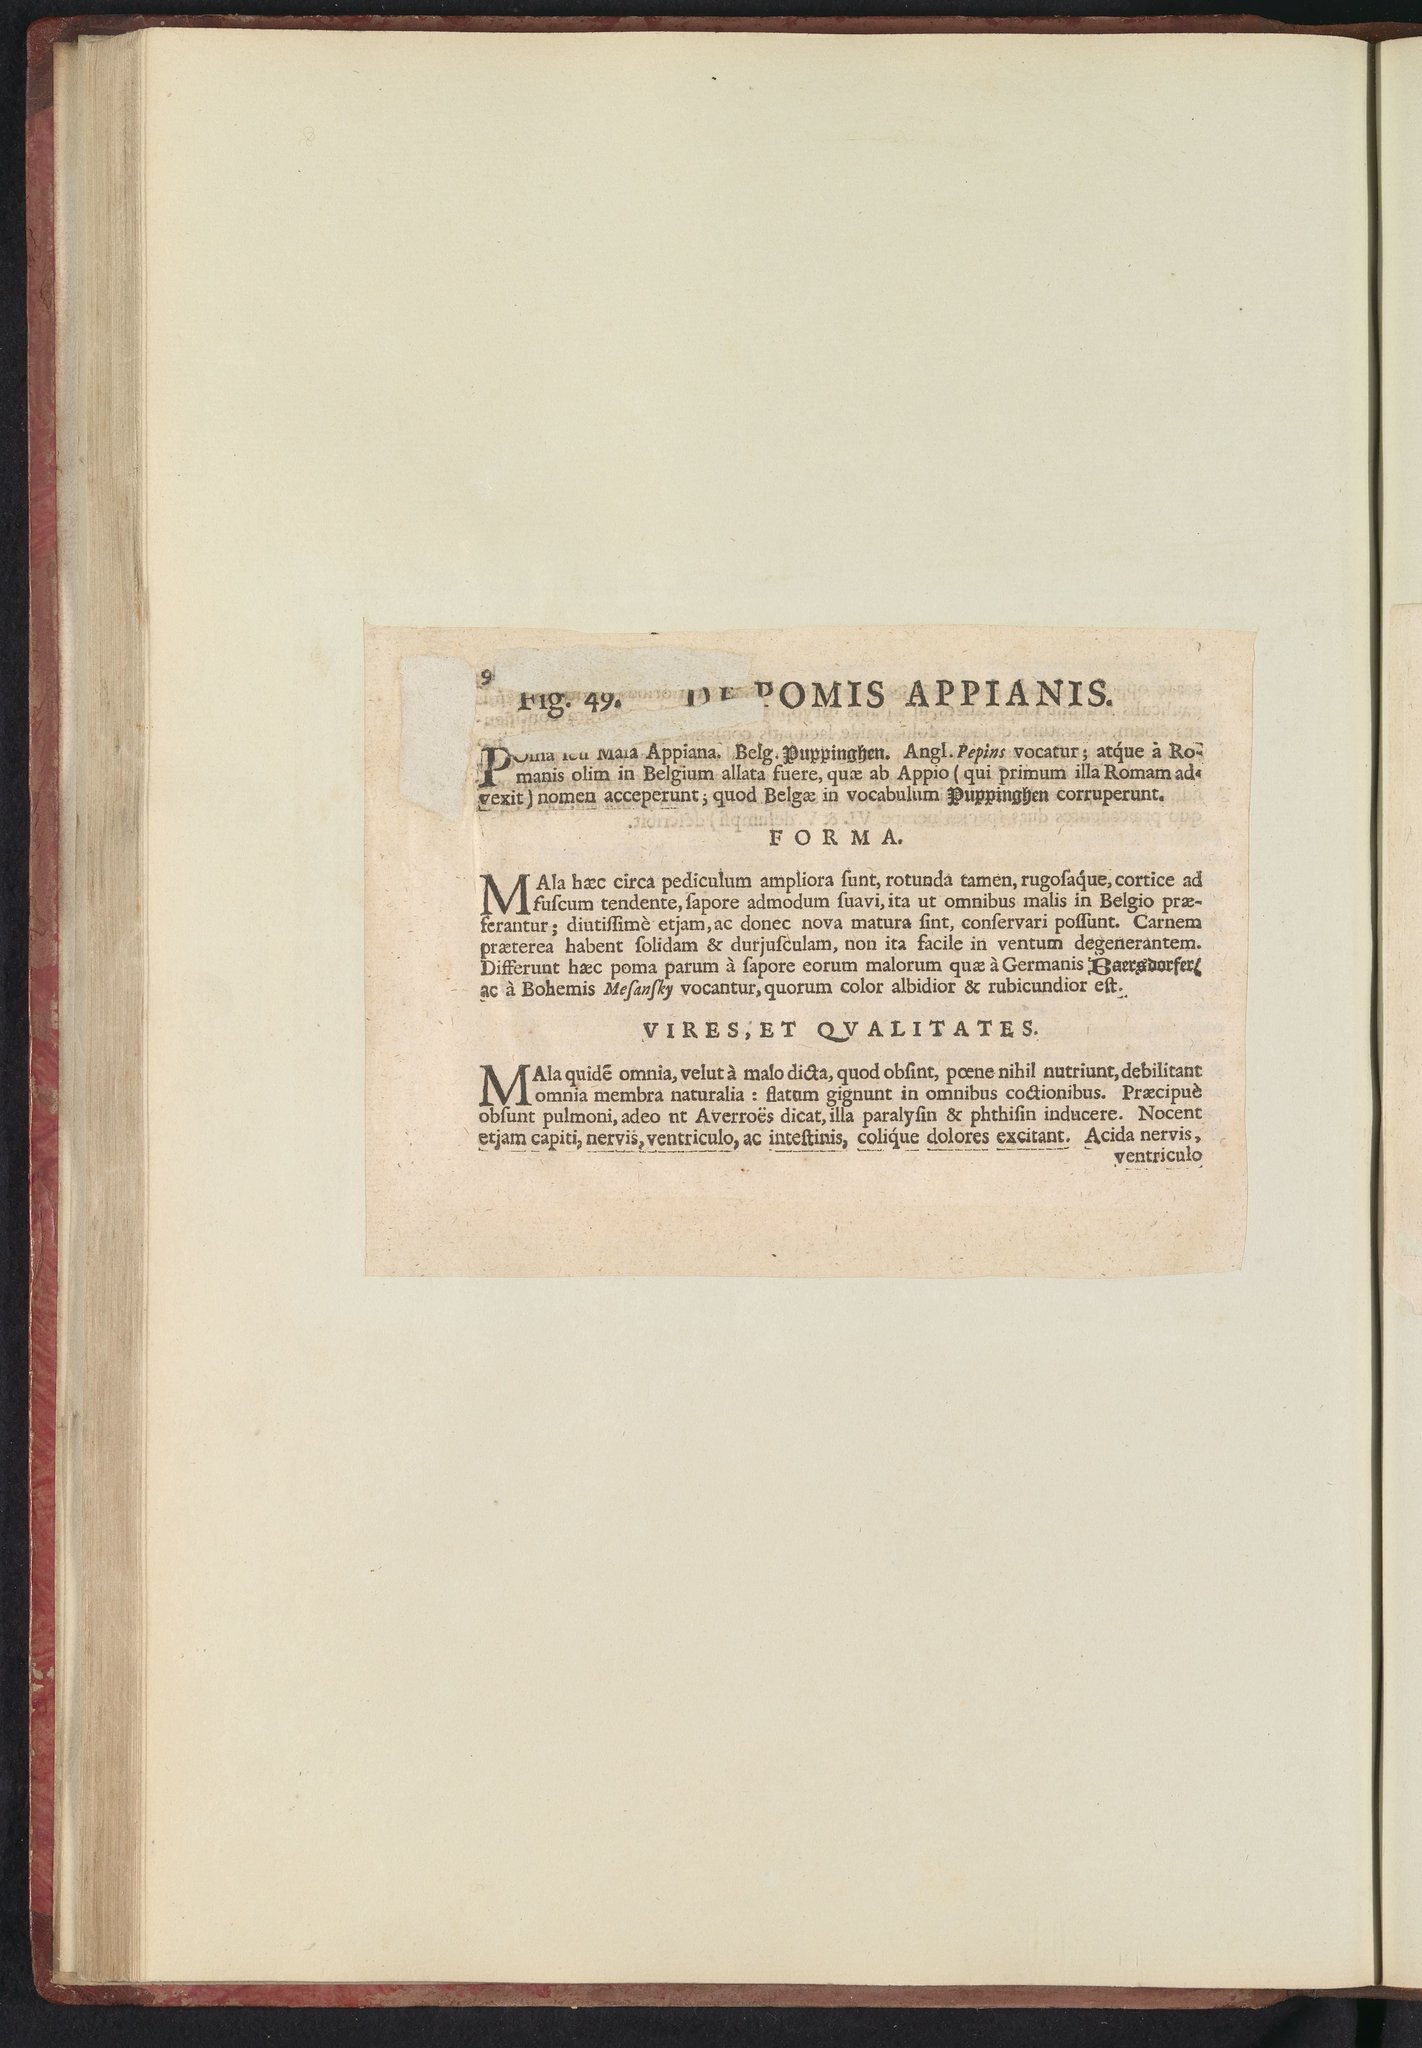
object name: text sheet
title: Fig. 49 'De Pomis Appianis' in De Boodts herbarium van 1640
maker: anselmus boëtius de boodt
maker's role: draughtsman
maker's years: 1550-1632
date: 1640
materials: ink, paper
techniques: letterpress printing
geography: bruges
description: Beschrijving bij Fig. 49 op p. 96 in: Anselmi Boëtii de Boot I.C. Brugensis & Rodolphi II. Imp. Roman. medici a cubiculis Florum, Herbarum, ac fructuum selectiorum icones, & vires pleraeque hactenus ignotæ. Onderdeel van het album met bladen en platen uit De Boodts herbarium van 1640. Het twaalfde van twaalf albums met aquarellen van dieren, vogels en planten bekend rond 1600, gemaakt in opdracht van keizer Rudolf II.